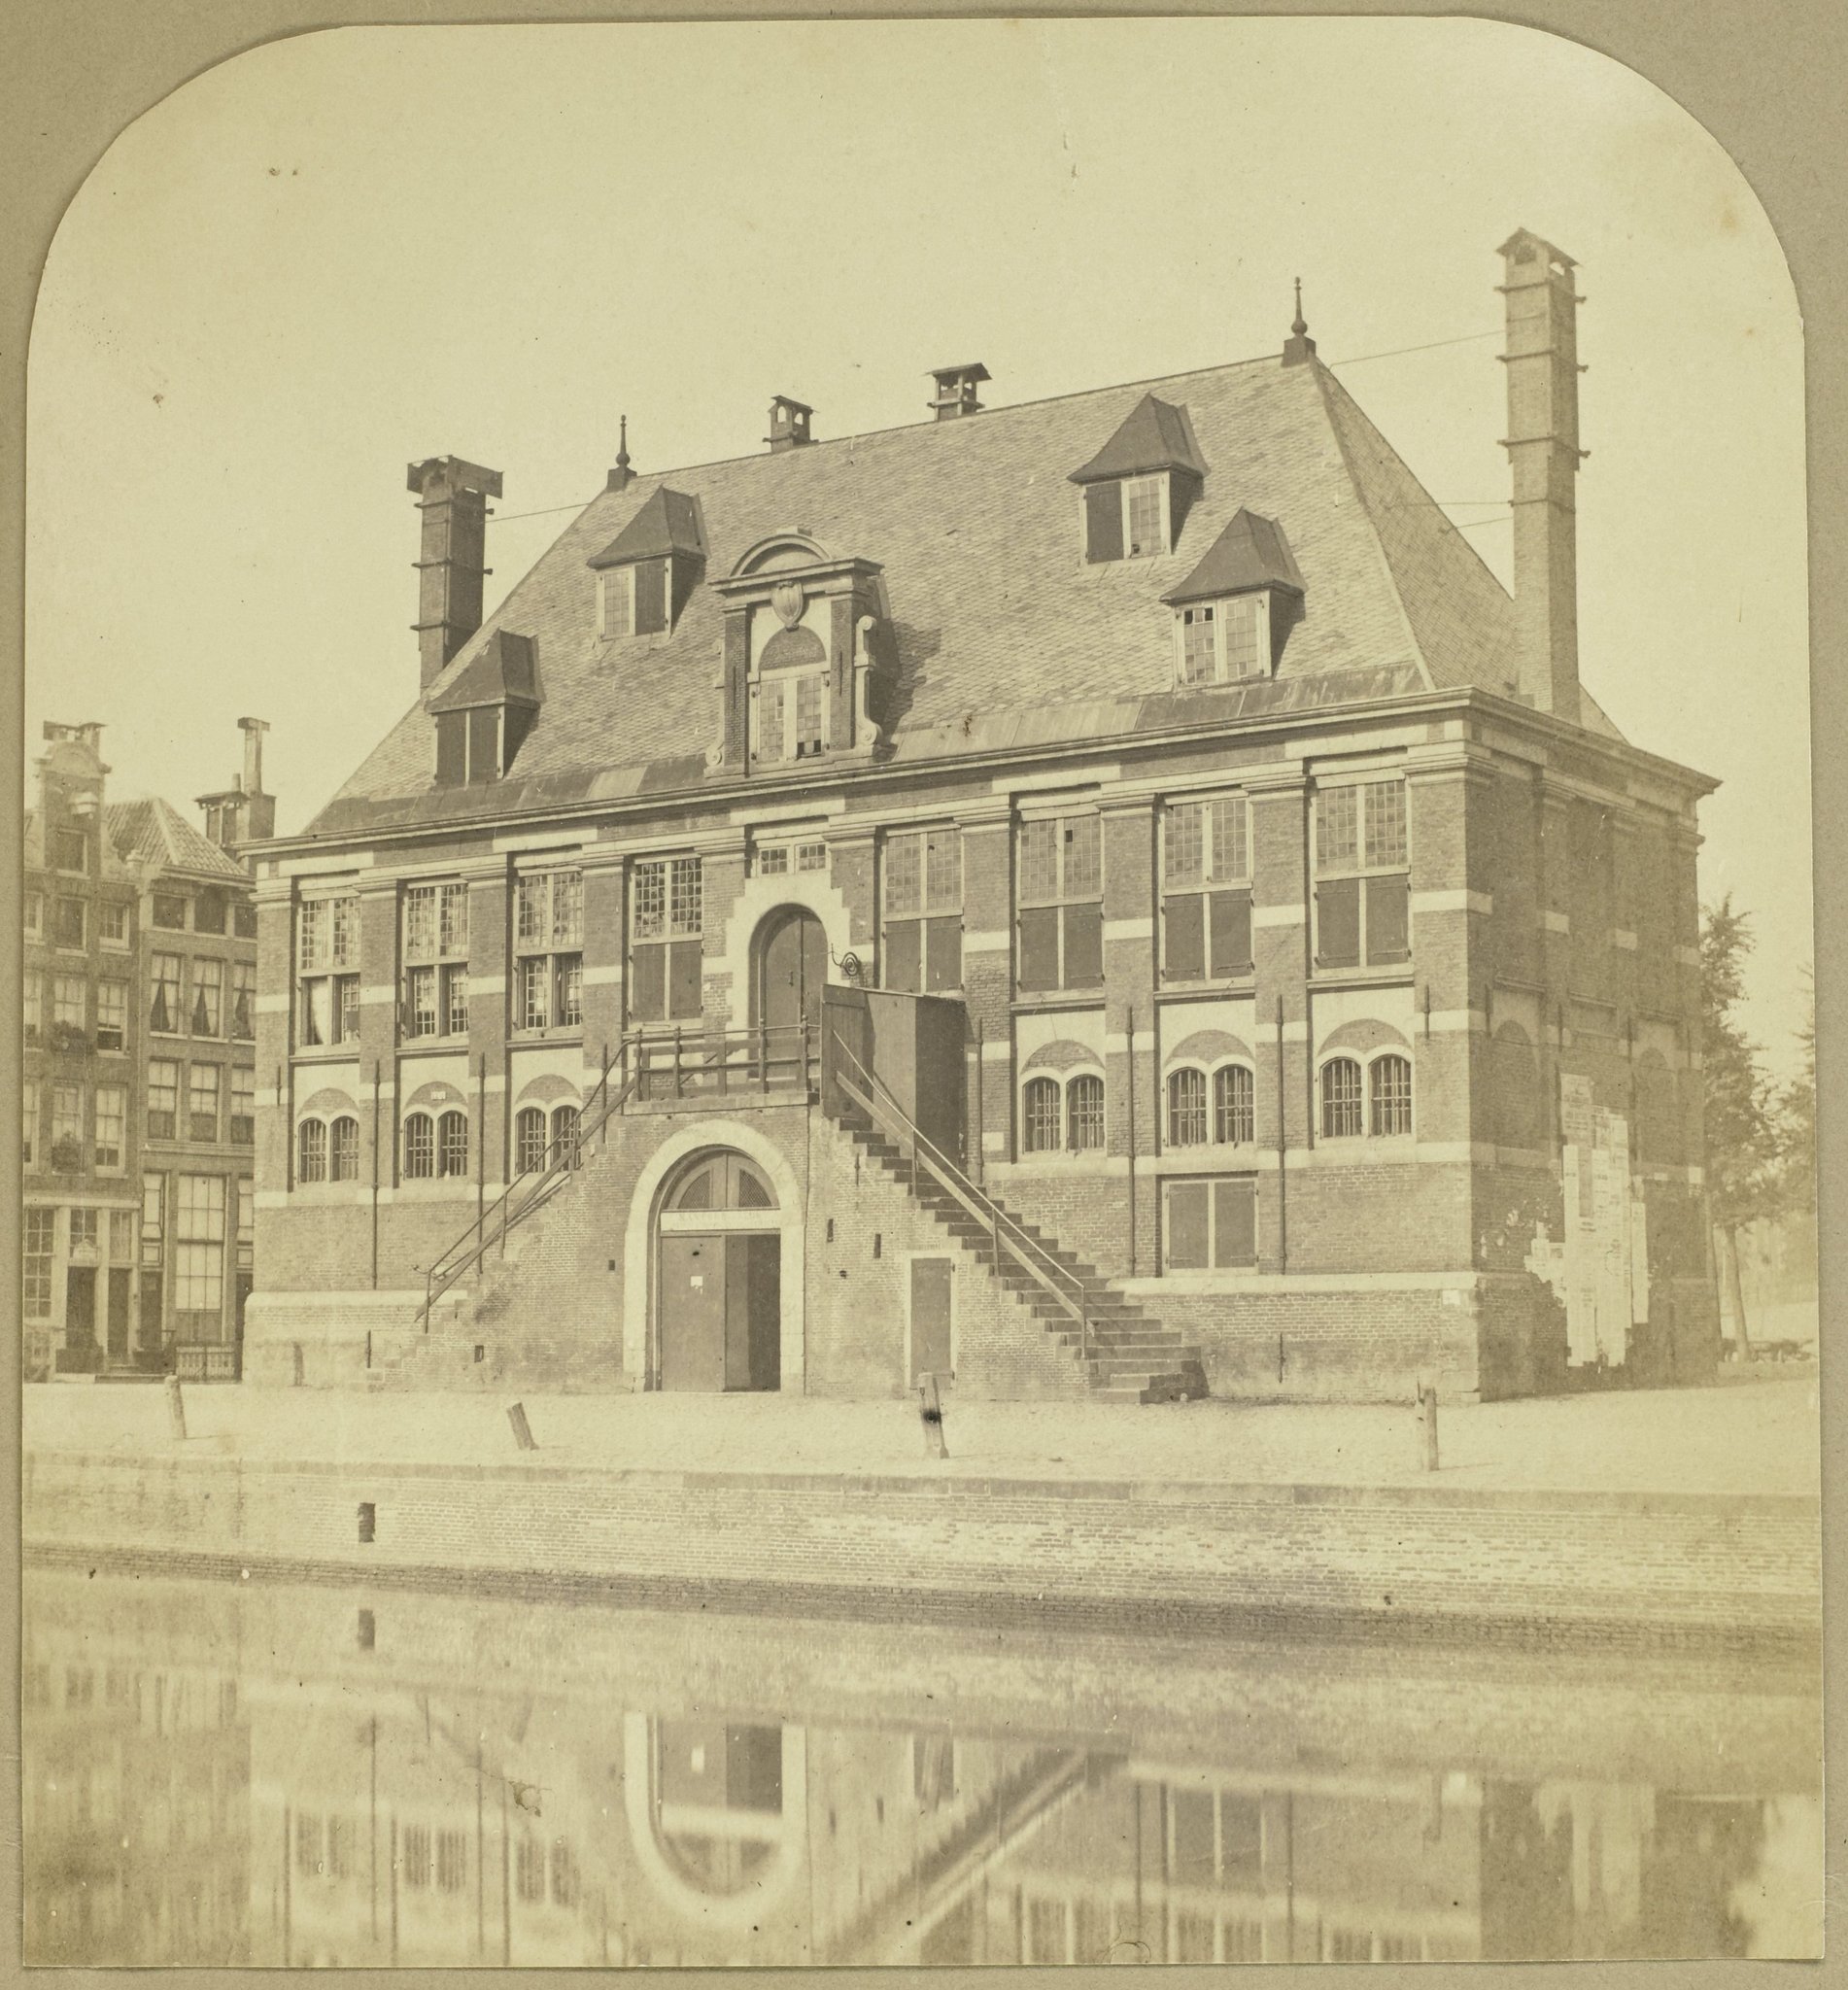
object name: photograph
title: Gezicht op de Westerhal op de Westermarkt in Amsterdam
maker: eduard isaac asser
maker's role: amateurfotograaf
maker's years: 1809-1894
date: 1855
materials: cardboard, paper, photographic support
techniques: salted paper print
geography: amsterdam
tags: westermarkt